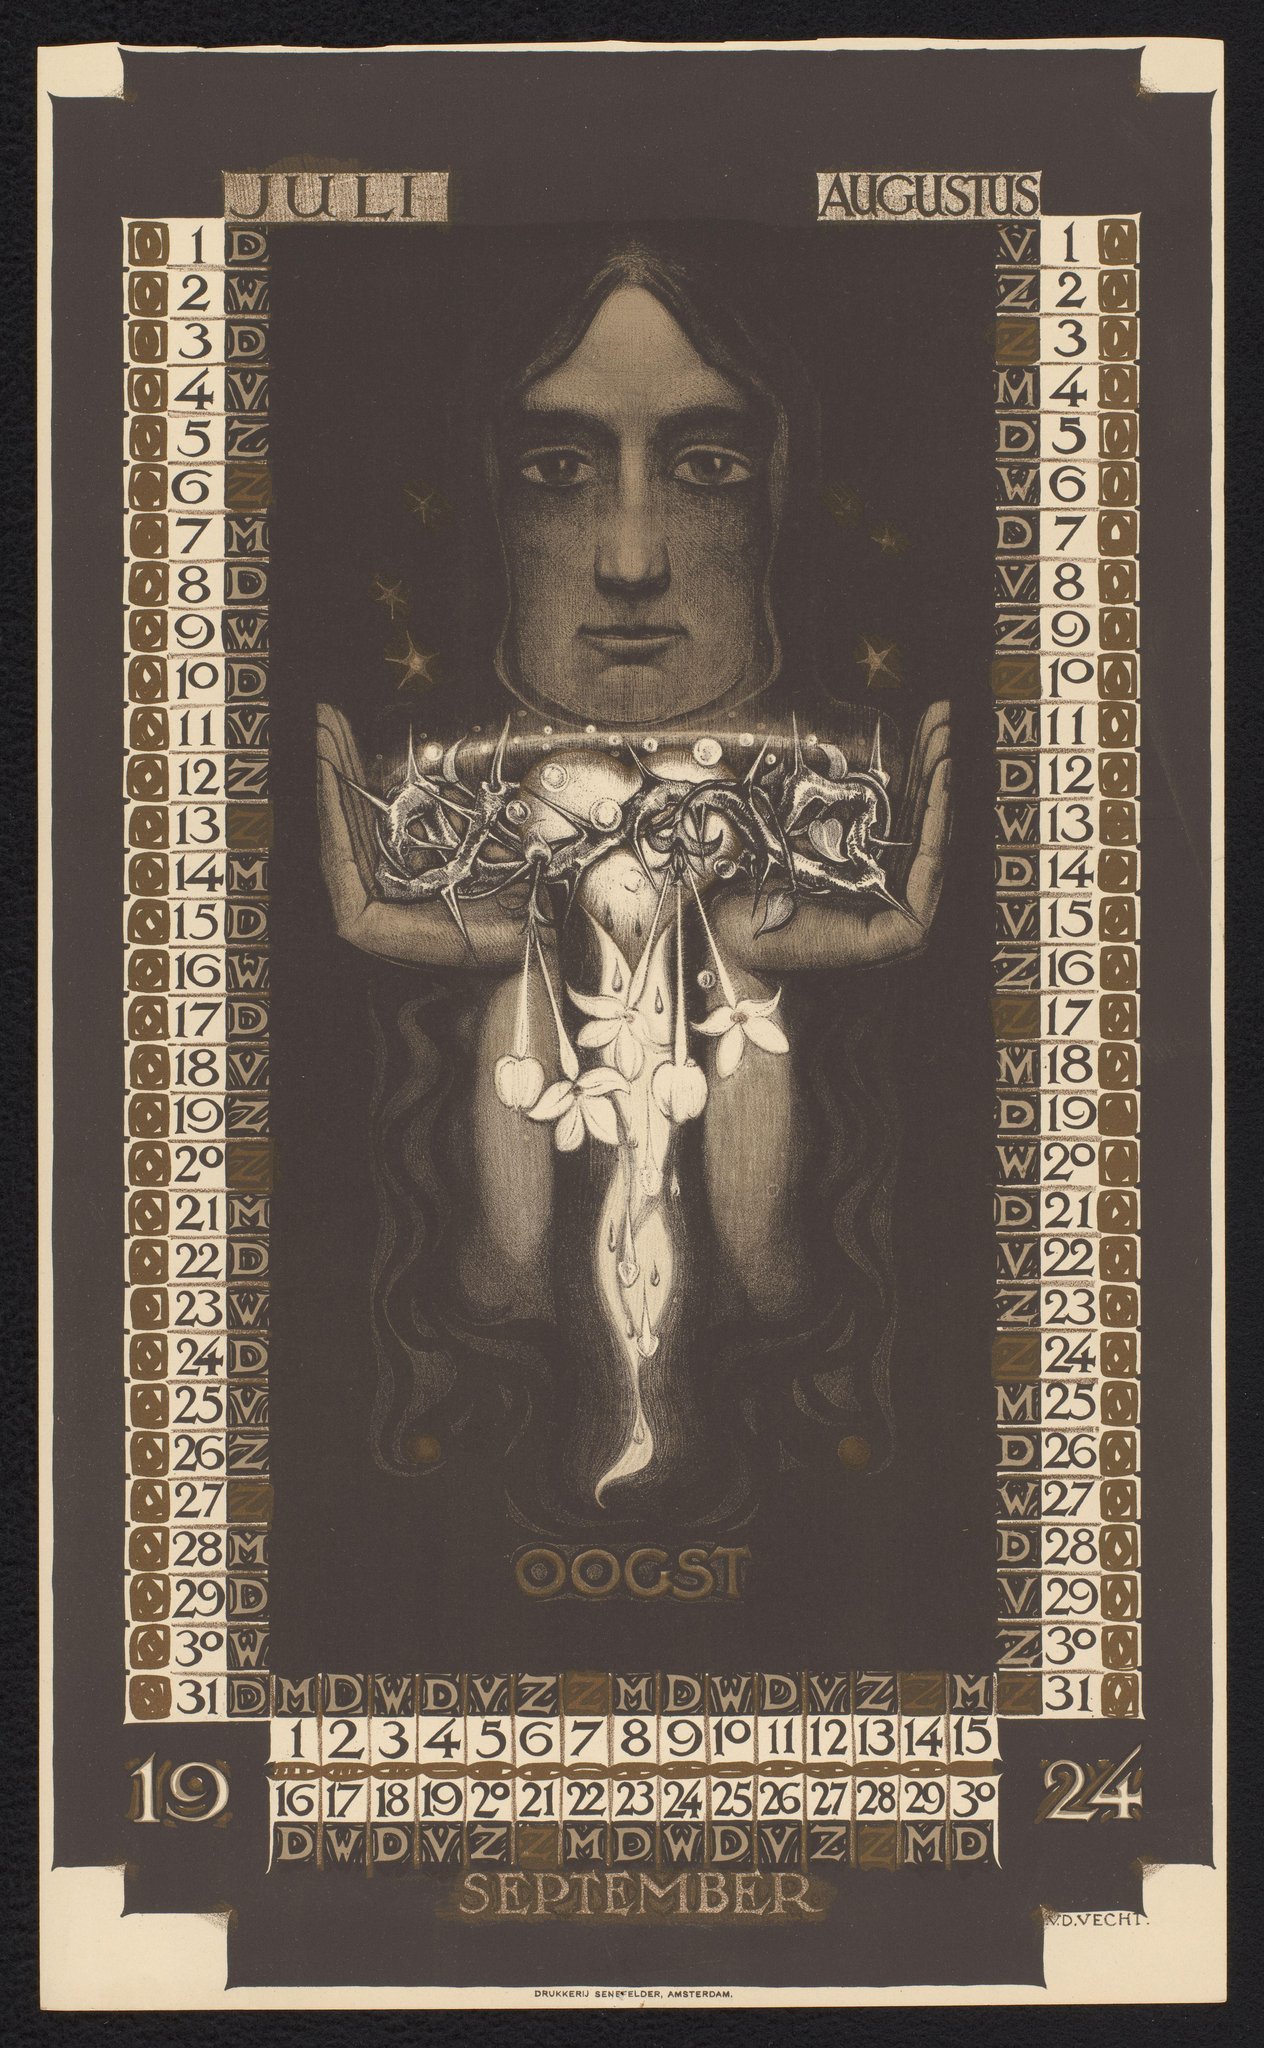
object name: print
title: Kalenderblad voor juli tot en met september 1924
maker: nicolaas van de vecht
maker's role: print maker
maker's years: 1886-1941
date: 1923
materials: paper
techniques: lithograph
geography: amsterdam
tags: calendar, almanac, the sacred heart, crown of thorns ~ instruments of the passion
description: Een in schaduwen gehuld gezicht met opgeheven handen. In de handen een bloedend hart met daarom een doornenkrans.